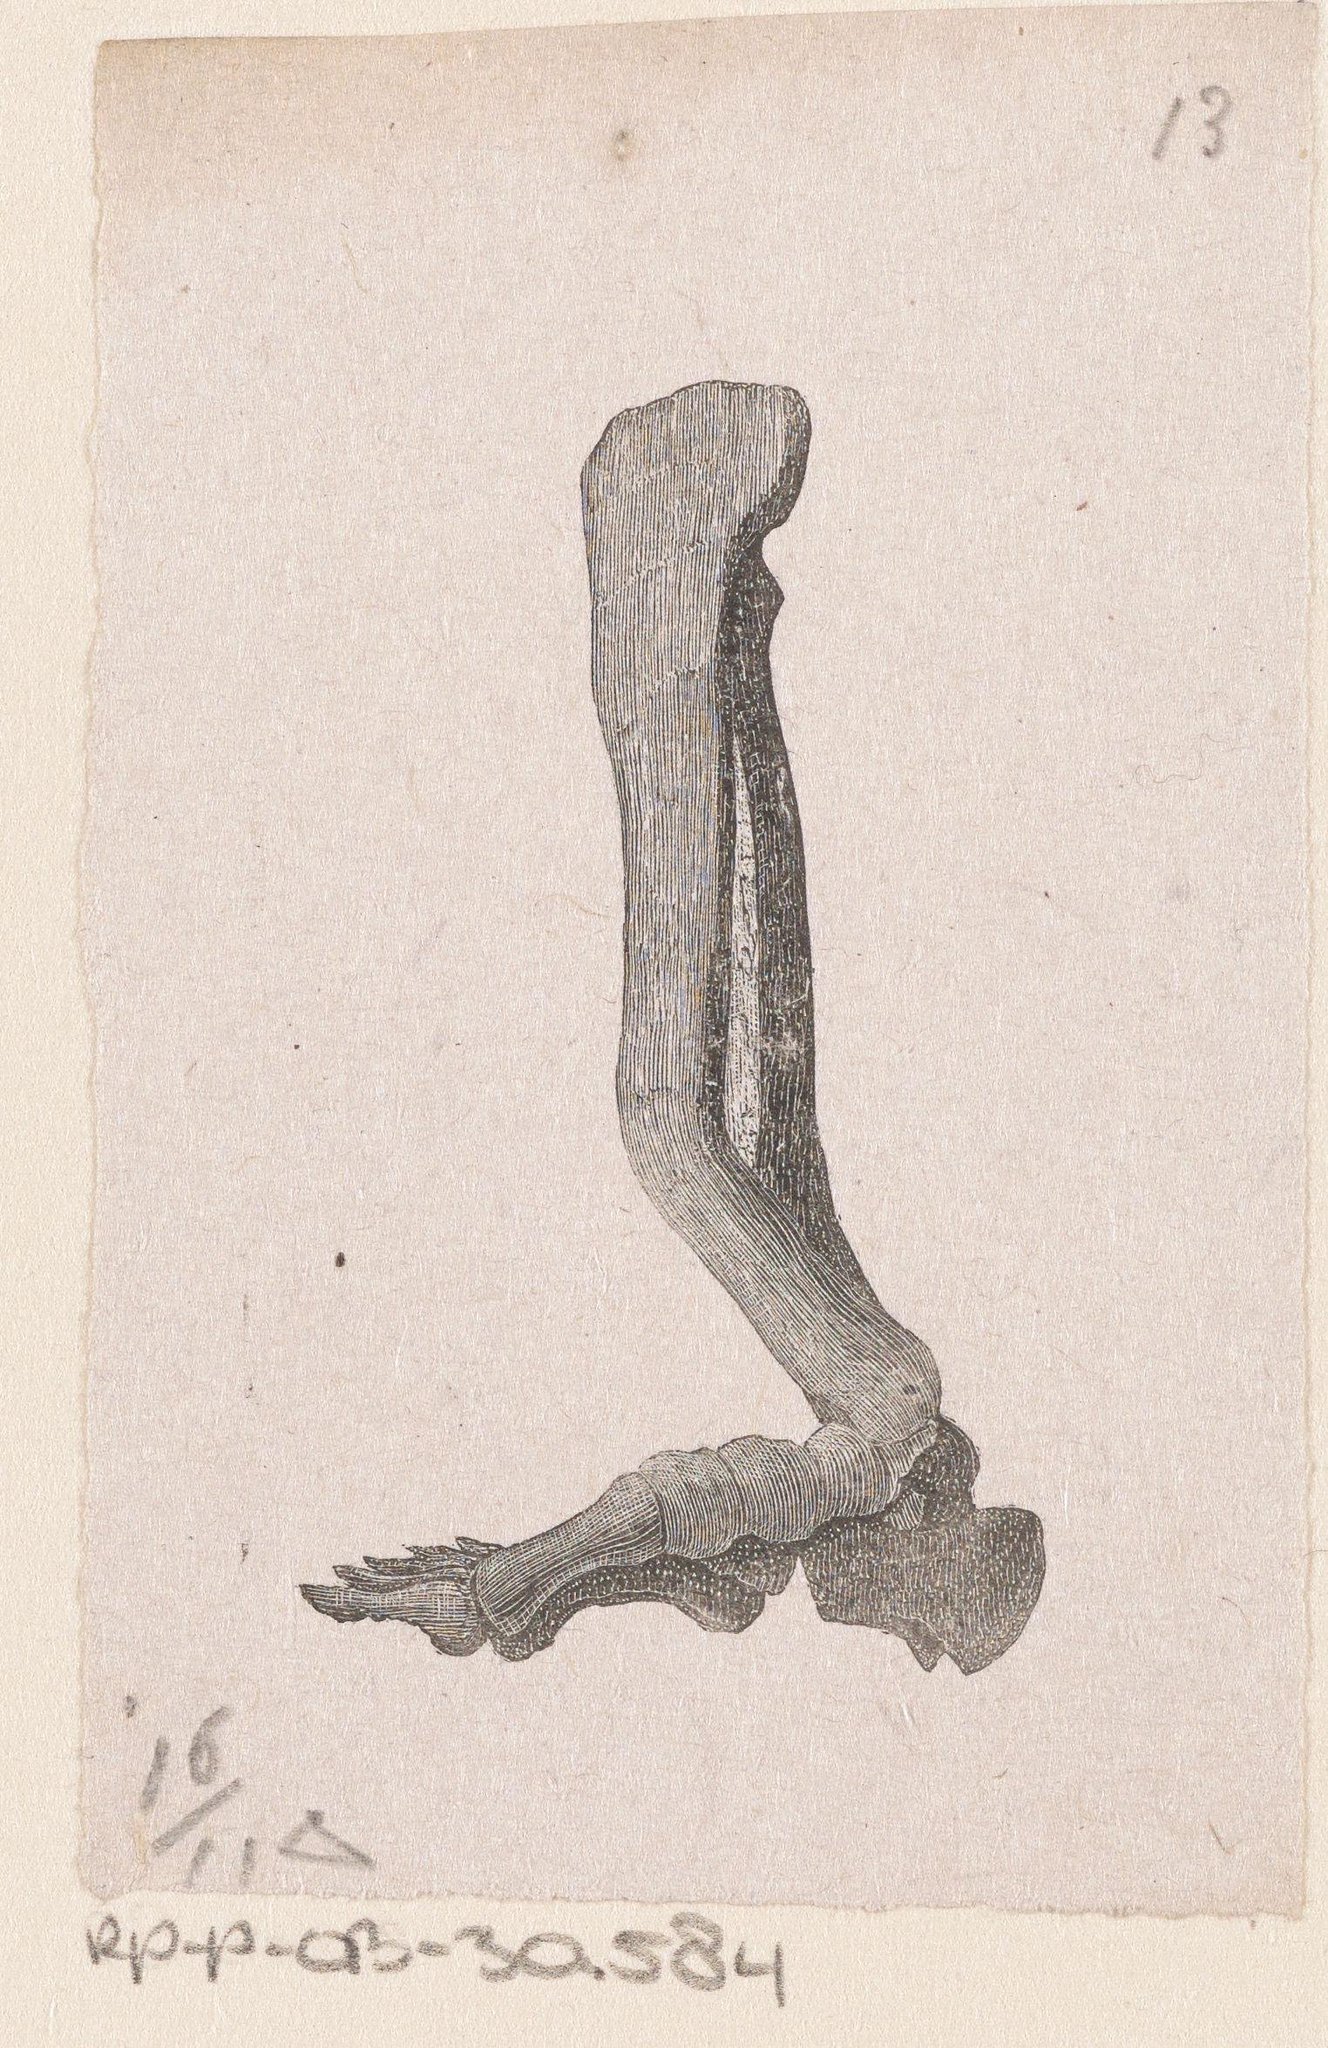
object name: print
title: Menselijk bot met een afwijking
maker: isaac weissenbruch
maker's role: print maker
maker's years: 1826-1912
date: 1836-1912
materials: paper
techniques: engraving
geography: netherlands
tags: diseases, bones of the legs